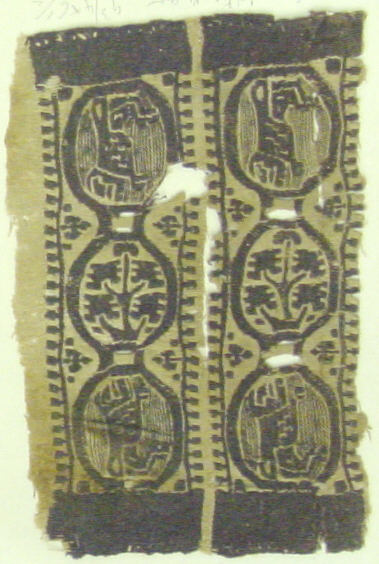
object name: textile fragment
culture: coptic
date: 501-600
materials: linen, wool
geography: egypt